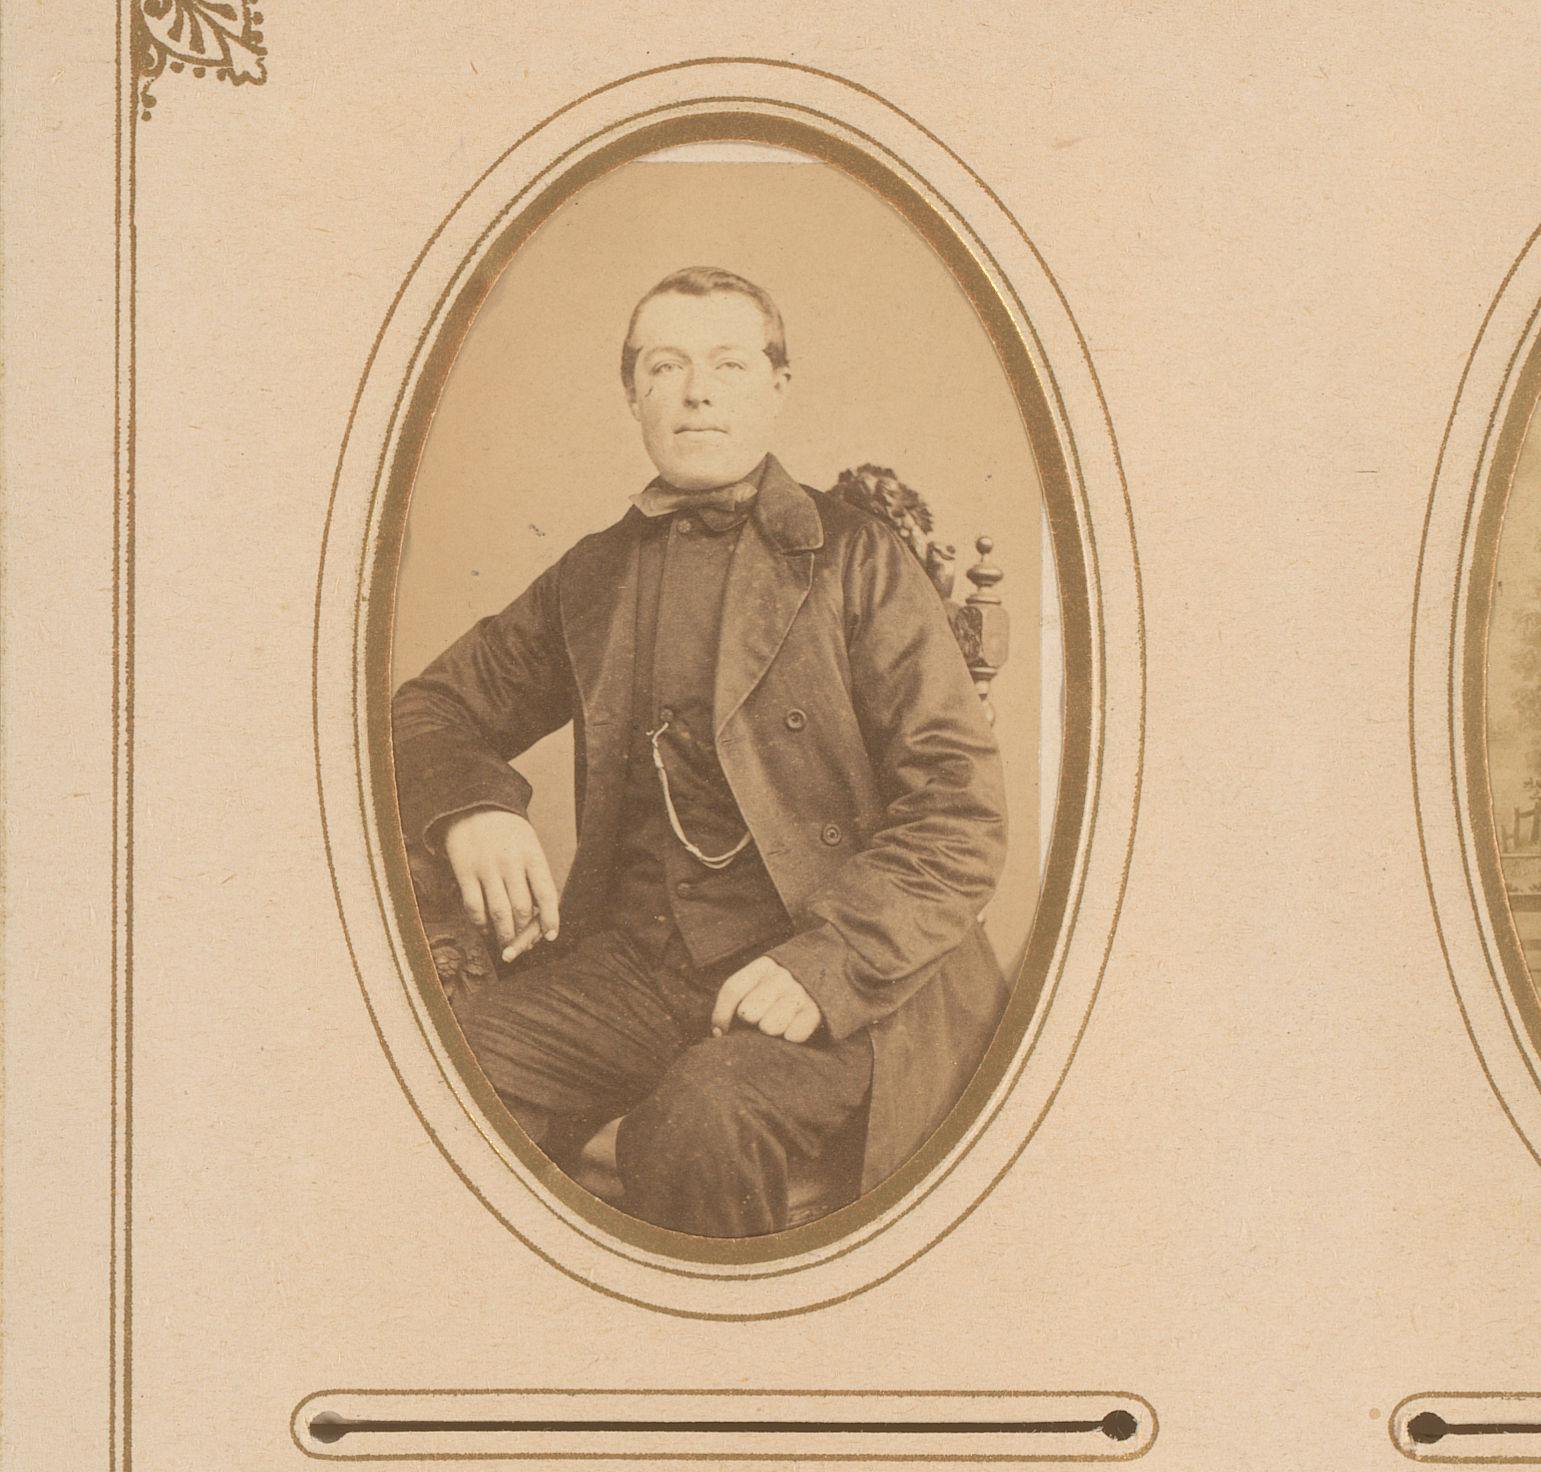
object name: carte de visite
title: Portret van een zittende man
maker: jan vels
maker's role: fotograaf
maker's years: 1825-1889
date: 1852-1889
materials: cardboard, photographic support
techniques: albumen print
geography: purmerend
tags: sitting figure, historical persons, chair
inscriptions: inscription: ‘J../ PHOTOGr ATELIER/ J. VELS./ bij de Kaasmarkt/ PURMEREND.’